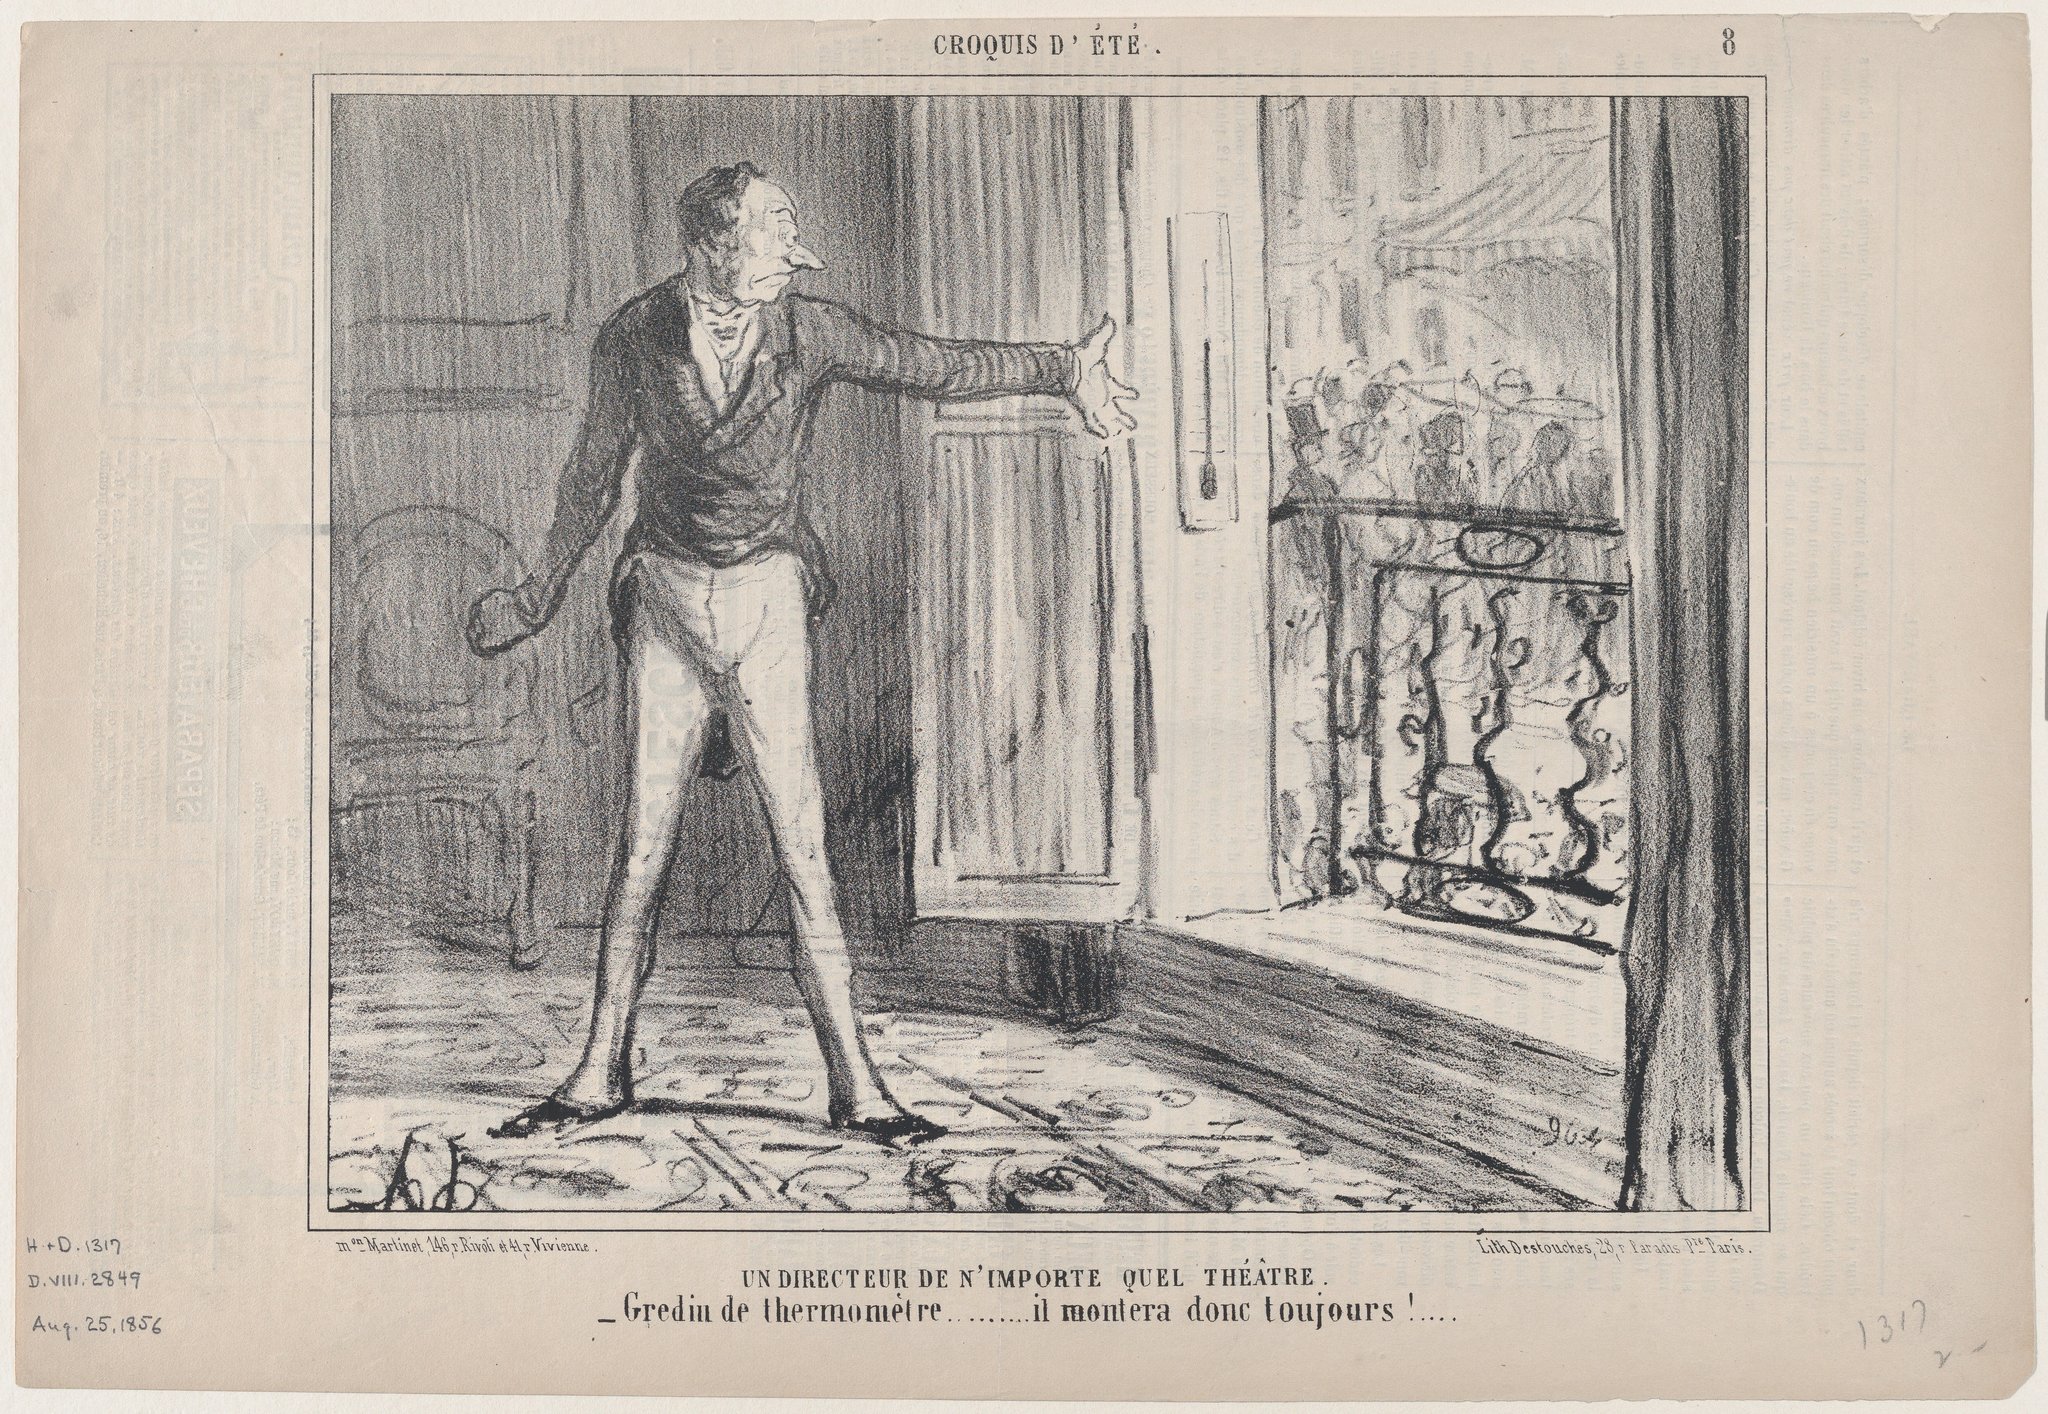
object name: print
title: Un Directeur de n'Importe quel Théâtre, from "Croquis d'Été"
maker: honoré daumier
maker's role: artist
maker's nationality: french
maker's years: 1808-1879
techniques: lithograph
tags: men,profiles